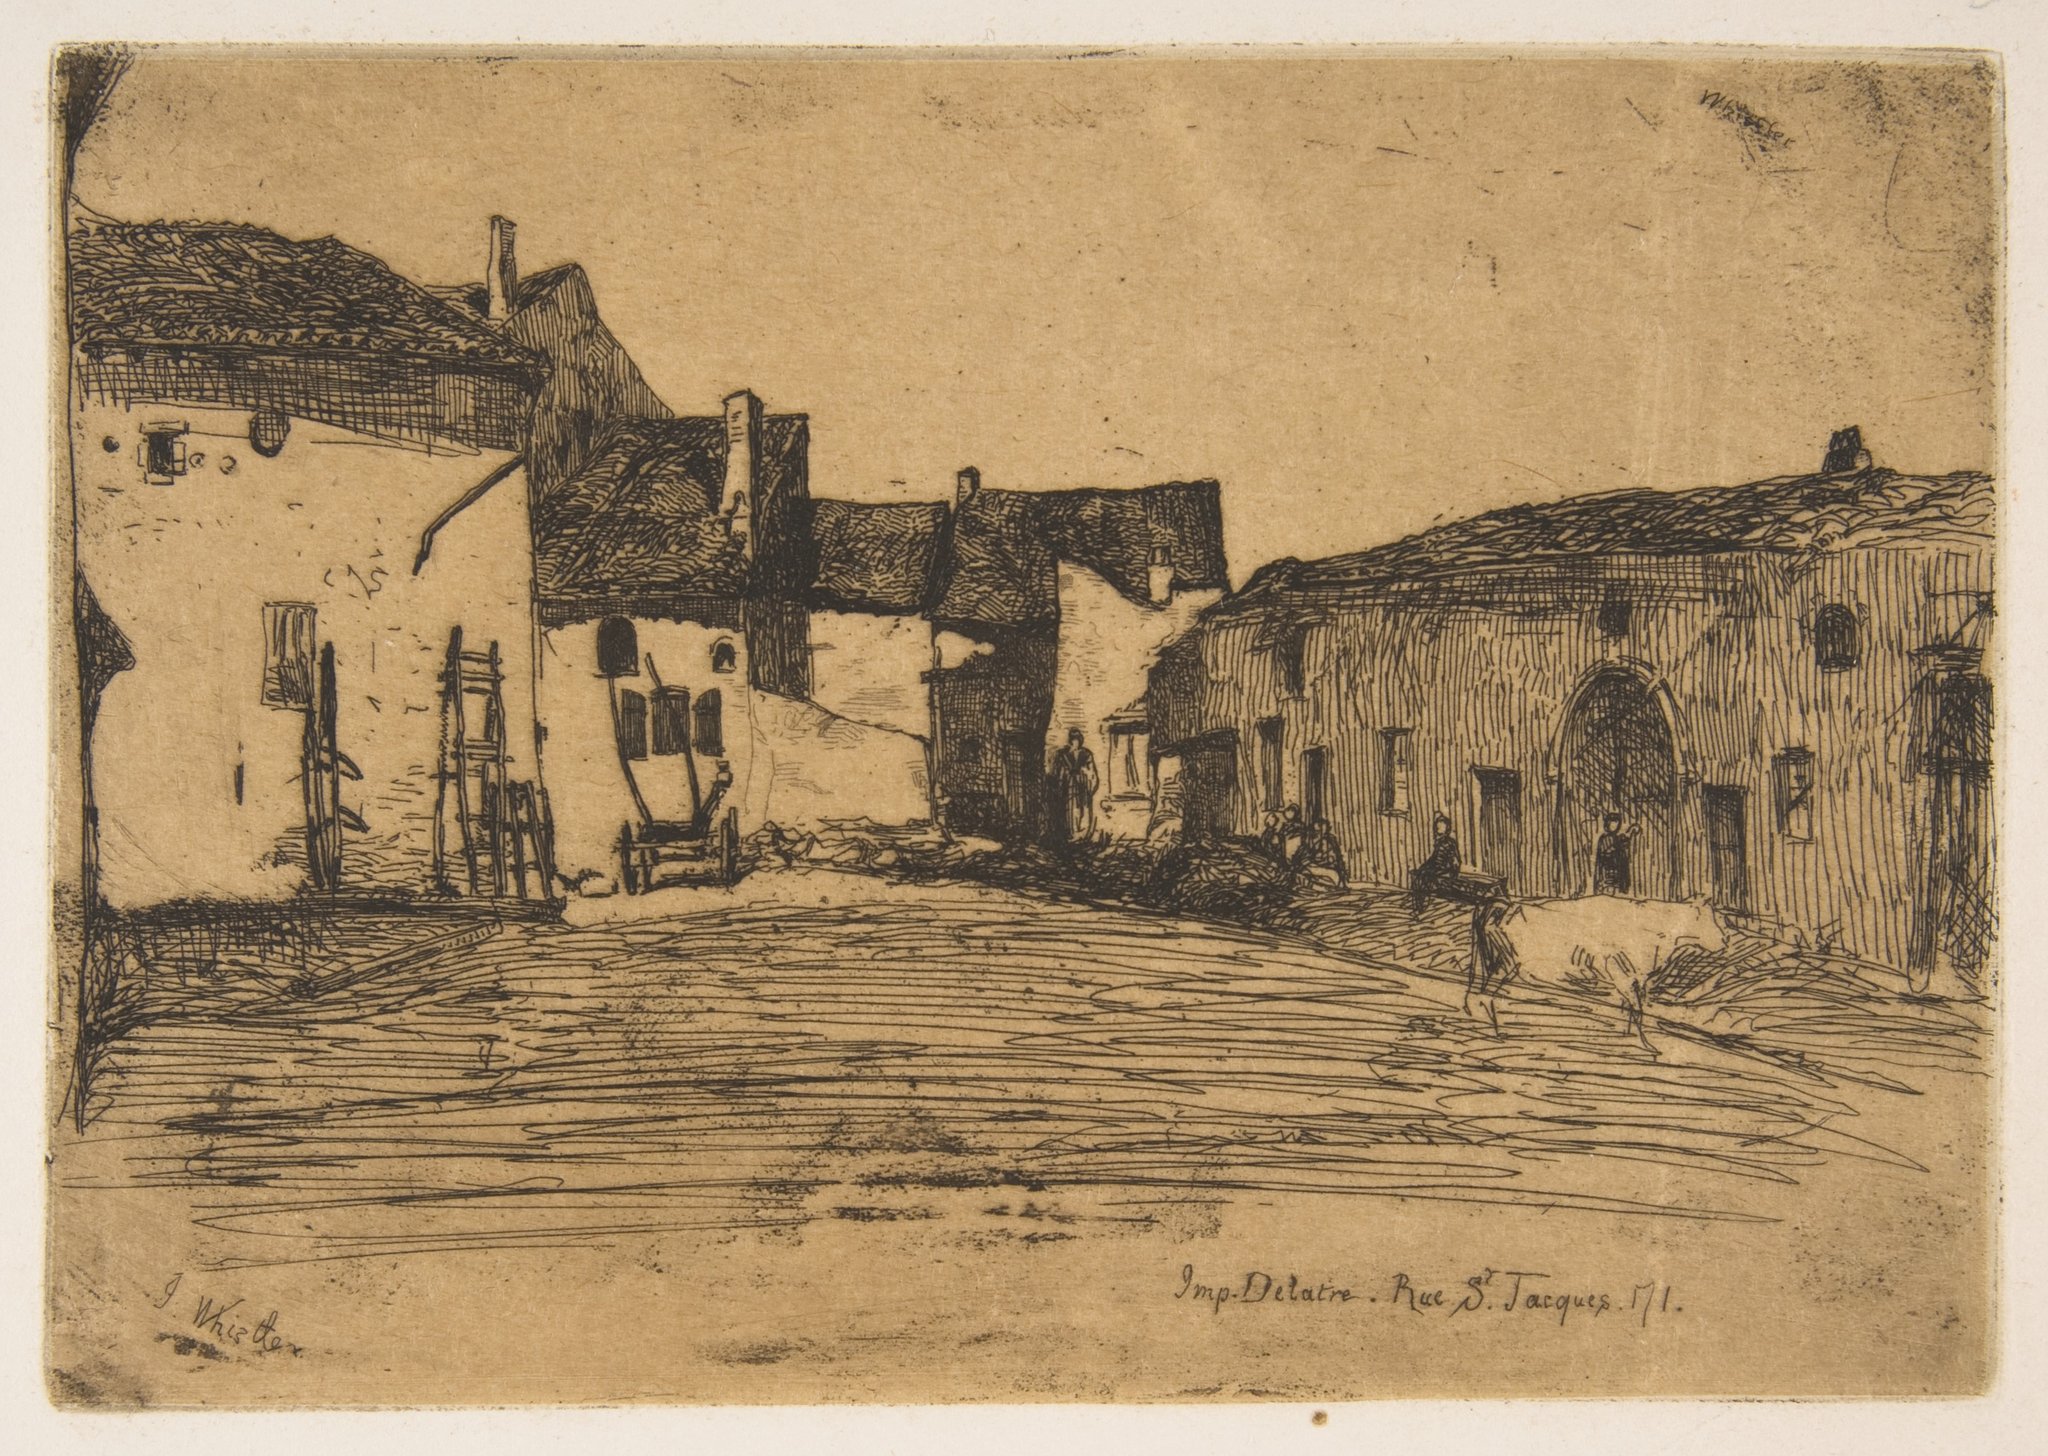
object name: print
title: Liverdun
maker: james mcneill whistler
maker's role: artist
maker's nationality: american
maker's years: 1834-1903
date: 1858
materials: chine, ink, paper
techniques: printmaking, etching, printing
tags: houses,cows